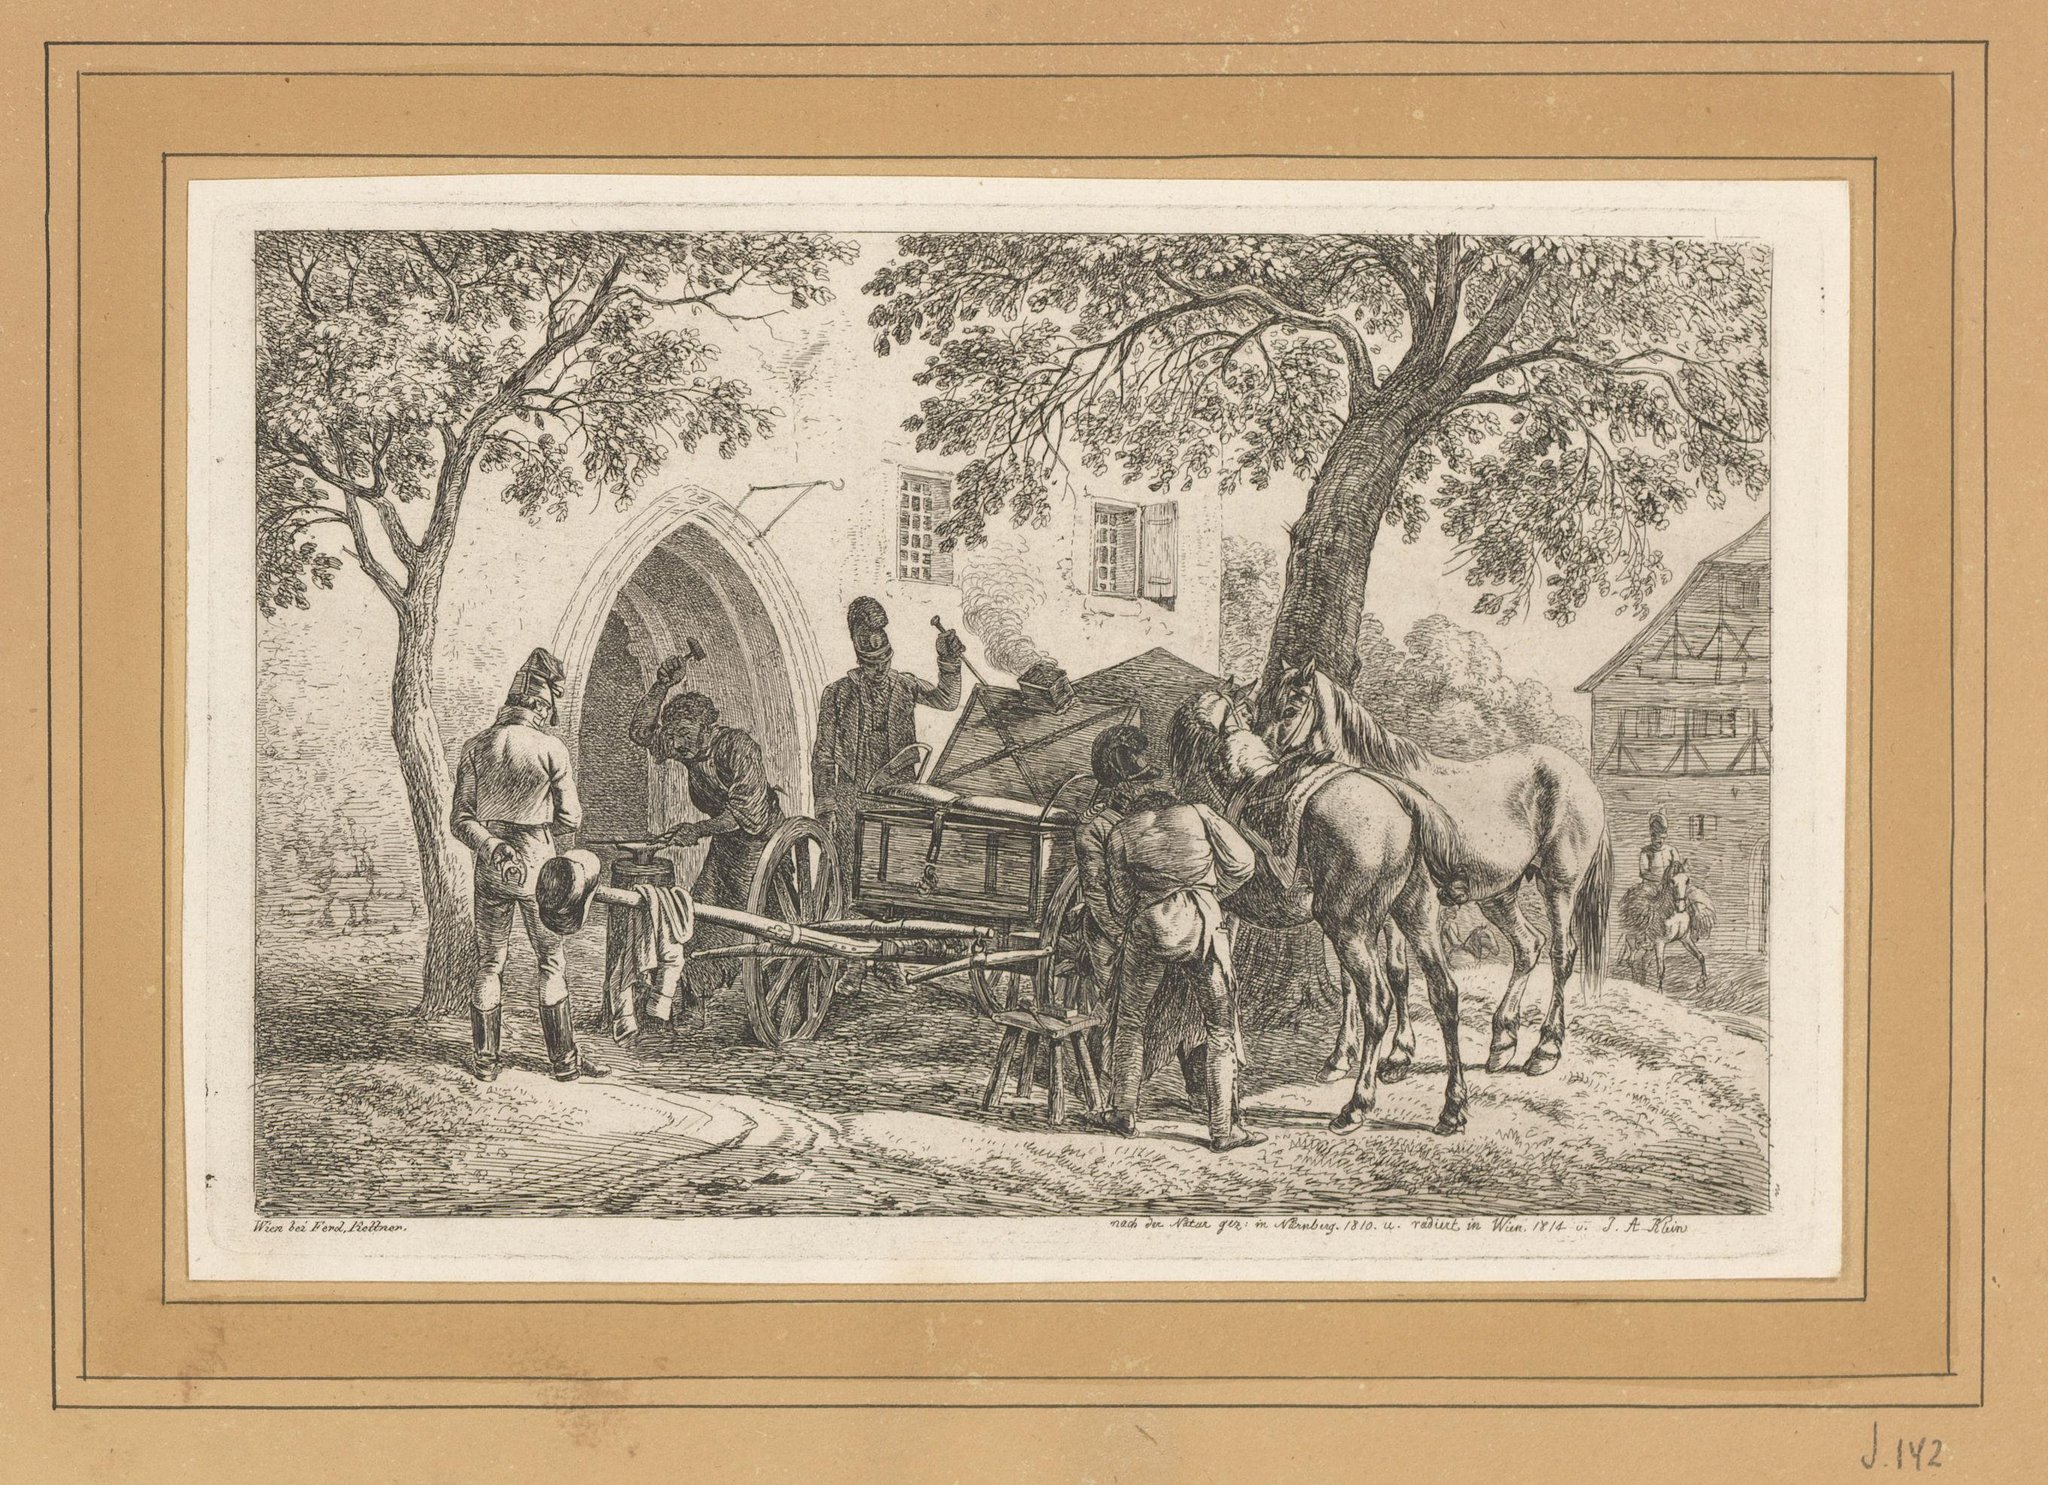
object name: print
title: Kurassiers bij de hoefsmid in Neurenberg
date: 1810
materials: paper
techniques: etching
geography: vienna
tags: farrier, shoeing-smith, private soldier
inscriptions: : Lugt 2760, collector's mark: Lugt 2228